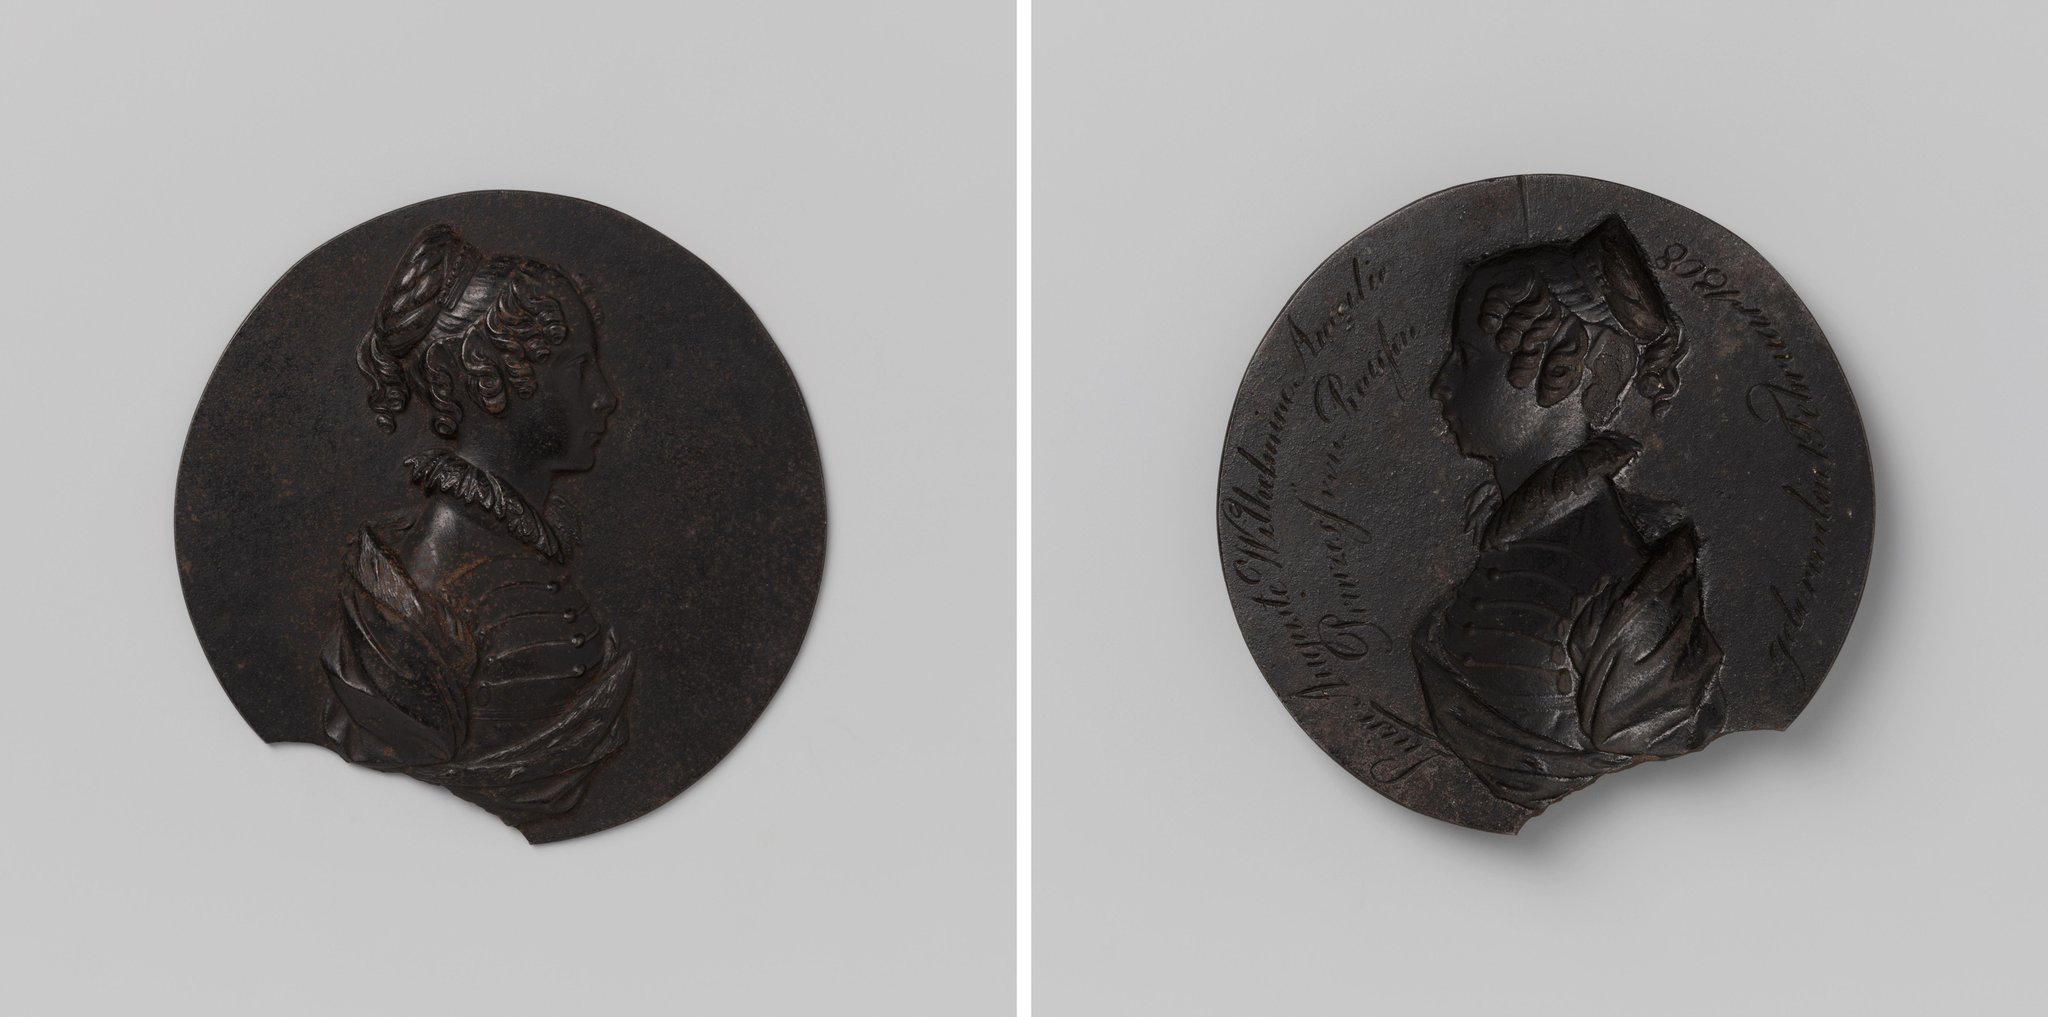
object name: plaque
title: Huwelijk van Frederik, prins der Nederlanden en Louise, prinses van Pruisen te Berlijn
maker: leonhard posch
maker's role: sculptor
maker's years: 1750-1831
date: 1825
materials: iron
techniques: casting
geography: berlin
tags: berlin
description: IJzeren penning. Voorzijde: borststuk vrouw naar rechts. Keerzijde: opschrift: "Luise Auguste Wilhelmine Amalie / Prinzess von Preussen / geboren den 1 Februar 1808".